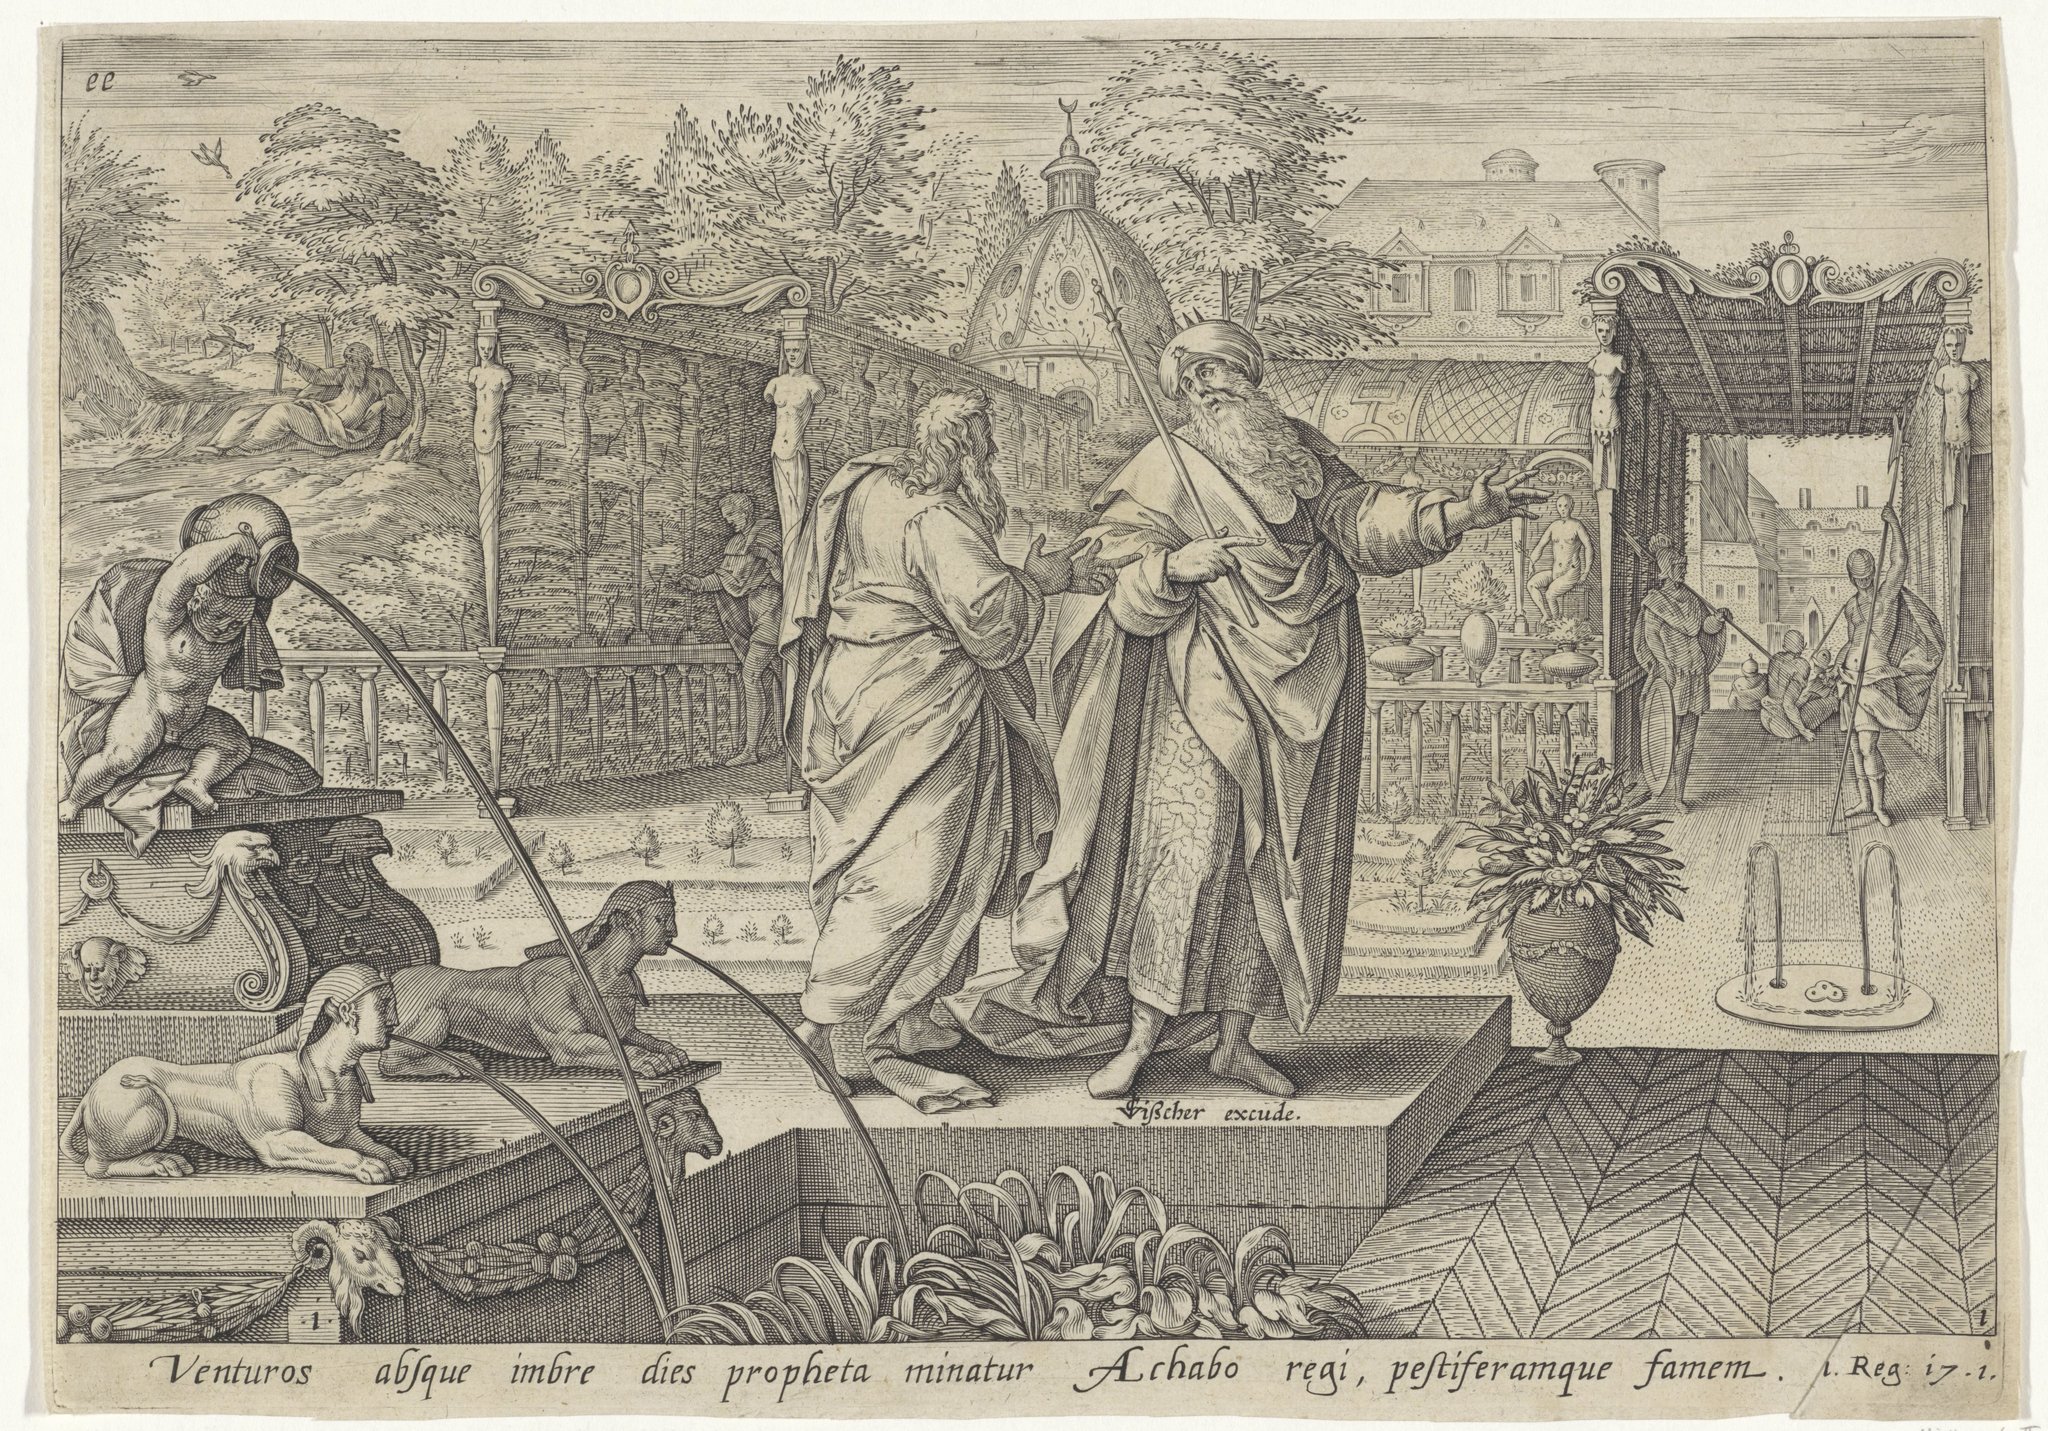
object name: print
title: Theatrum biblicum (...)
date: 1579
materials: paper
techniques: engraving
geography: amsterdam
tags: elijah announces to king ahab that god will bring a long drought in the land to avenge the apostasy of israel, elijah fed by the raven(s): while the prophet is living by the brook, ravens bring him food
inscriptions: collector's mark: Lugt 2228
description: Prent gebruikt in: Theatrum biblicum : hoc est historiae sacrae veteris et novi testamenti tabulis aeneis expressae. Opus praesentatissimorum huius ac superioris seculi pictorum atque sculptorum, summo studio conquisitum et in lucem editum. Amsterdam: Claes Jansz. Visscher, 1643.